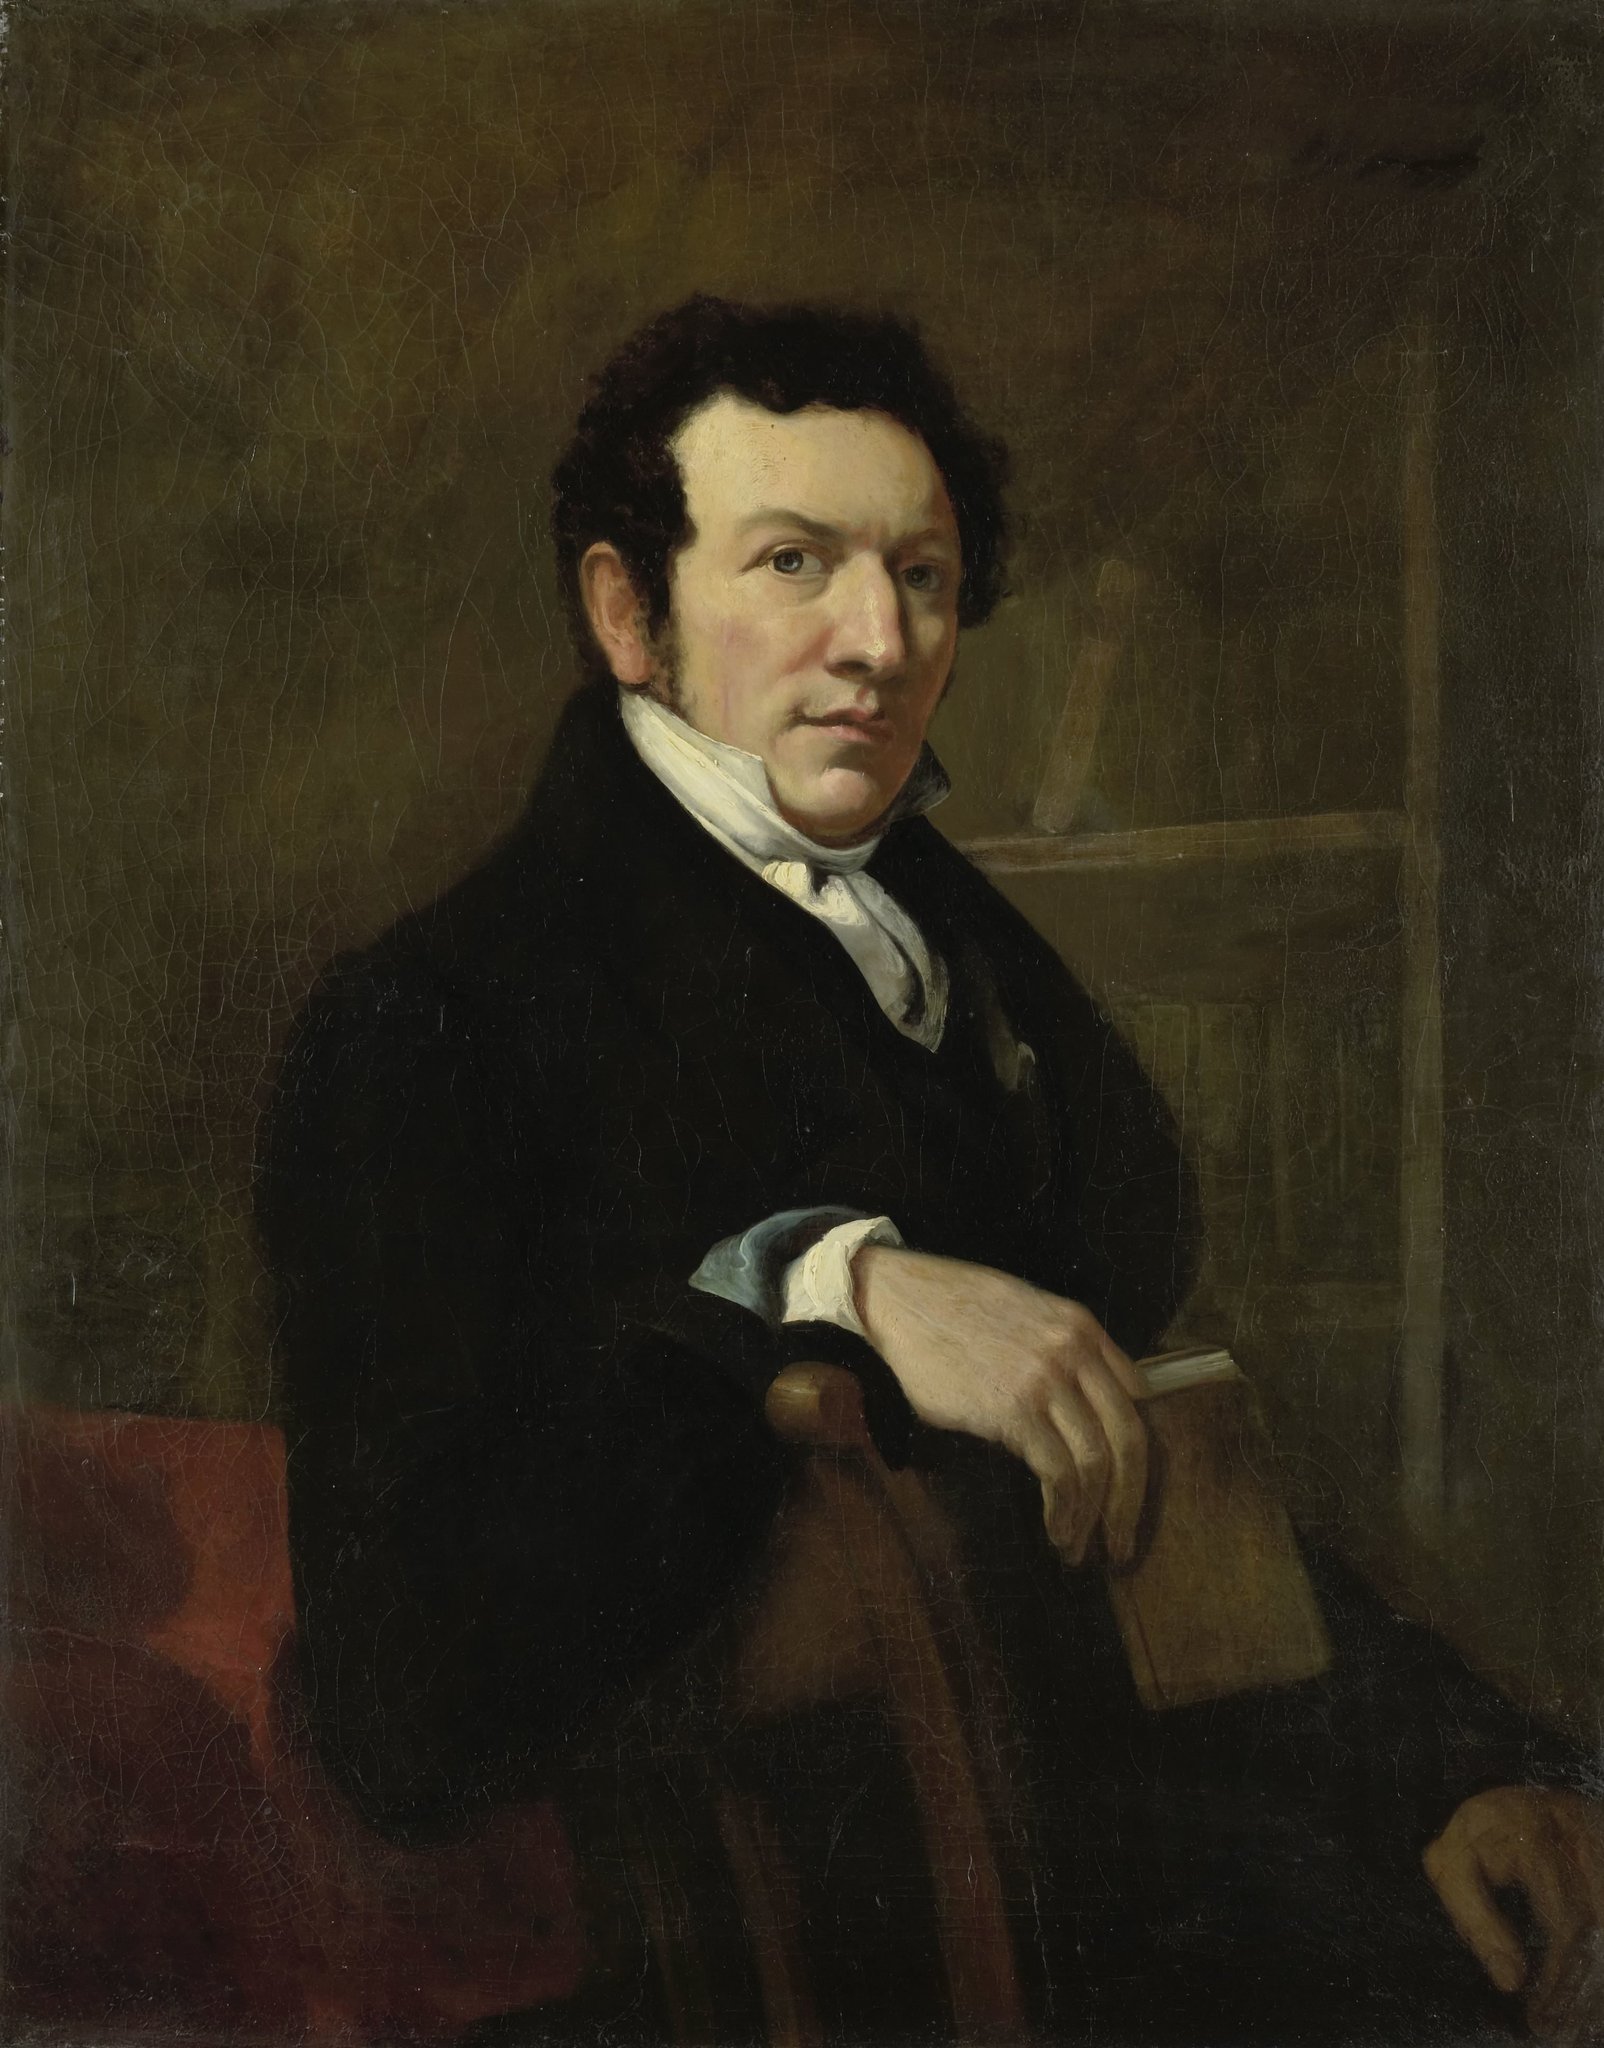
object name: painting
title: Portrait of Anthonie van der Hout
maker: christiaan julius lodewijk portman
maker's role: draughtsman, painter, print maker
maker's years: 1799-1868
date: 1826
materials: canvas, oil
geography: netherlands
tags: anthonie van der hout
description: Portret van Anthonie van der Hout (1783-1859). Ten halven lijve, zittend op een stoel met de rechterarm over de stoelleuning en met een boek in de hand. Pendant van SK-A-4168.